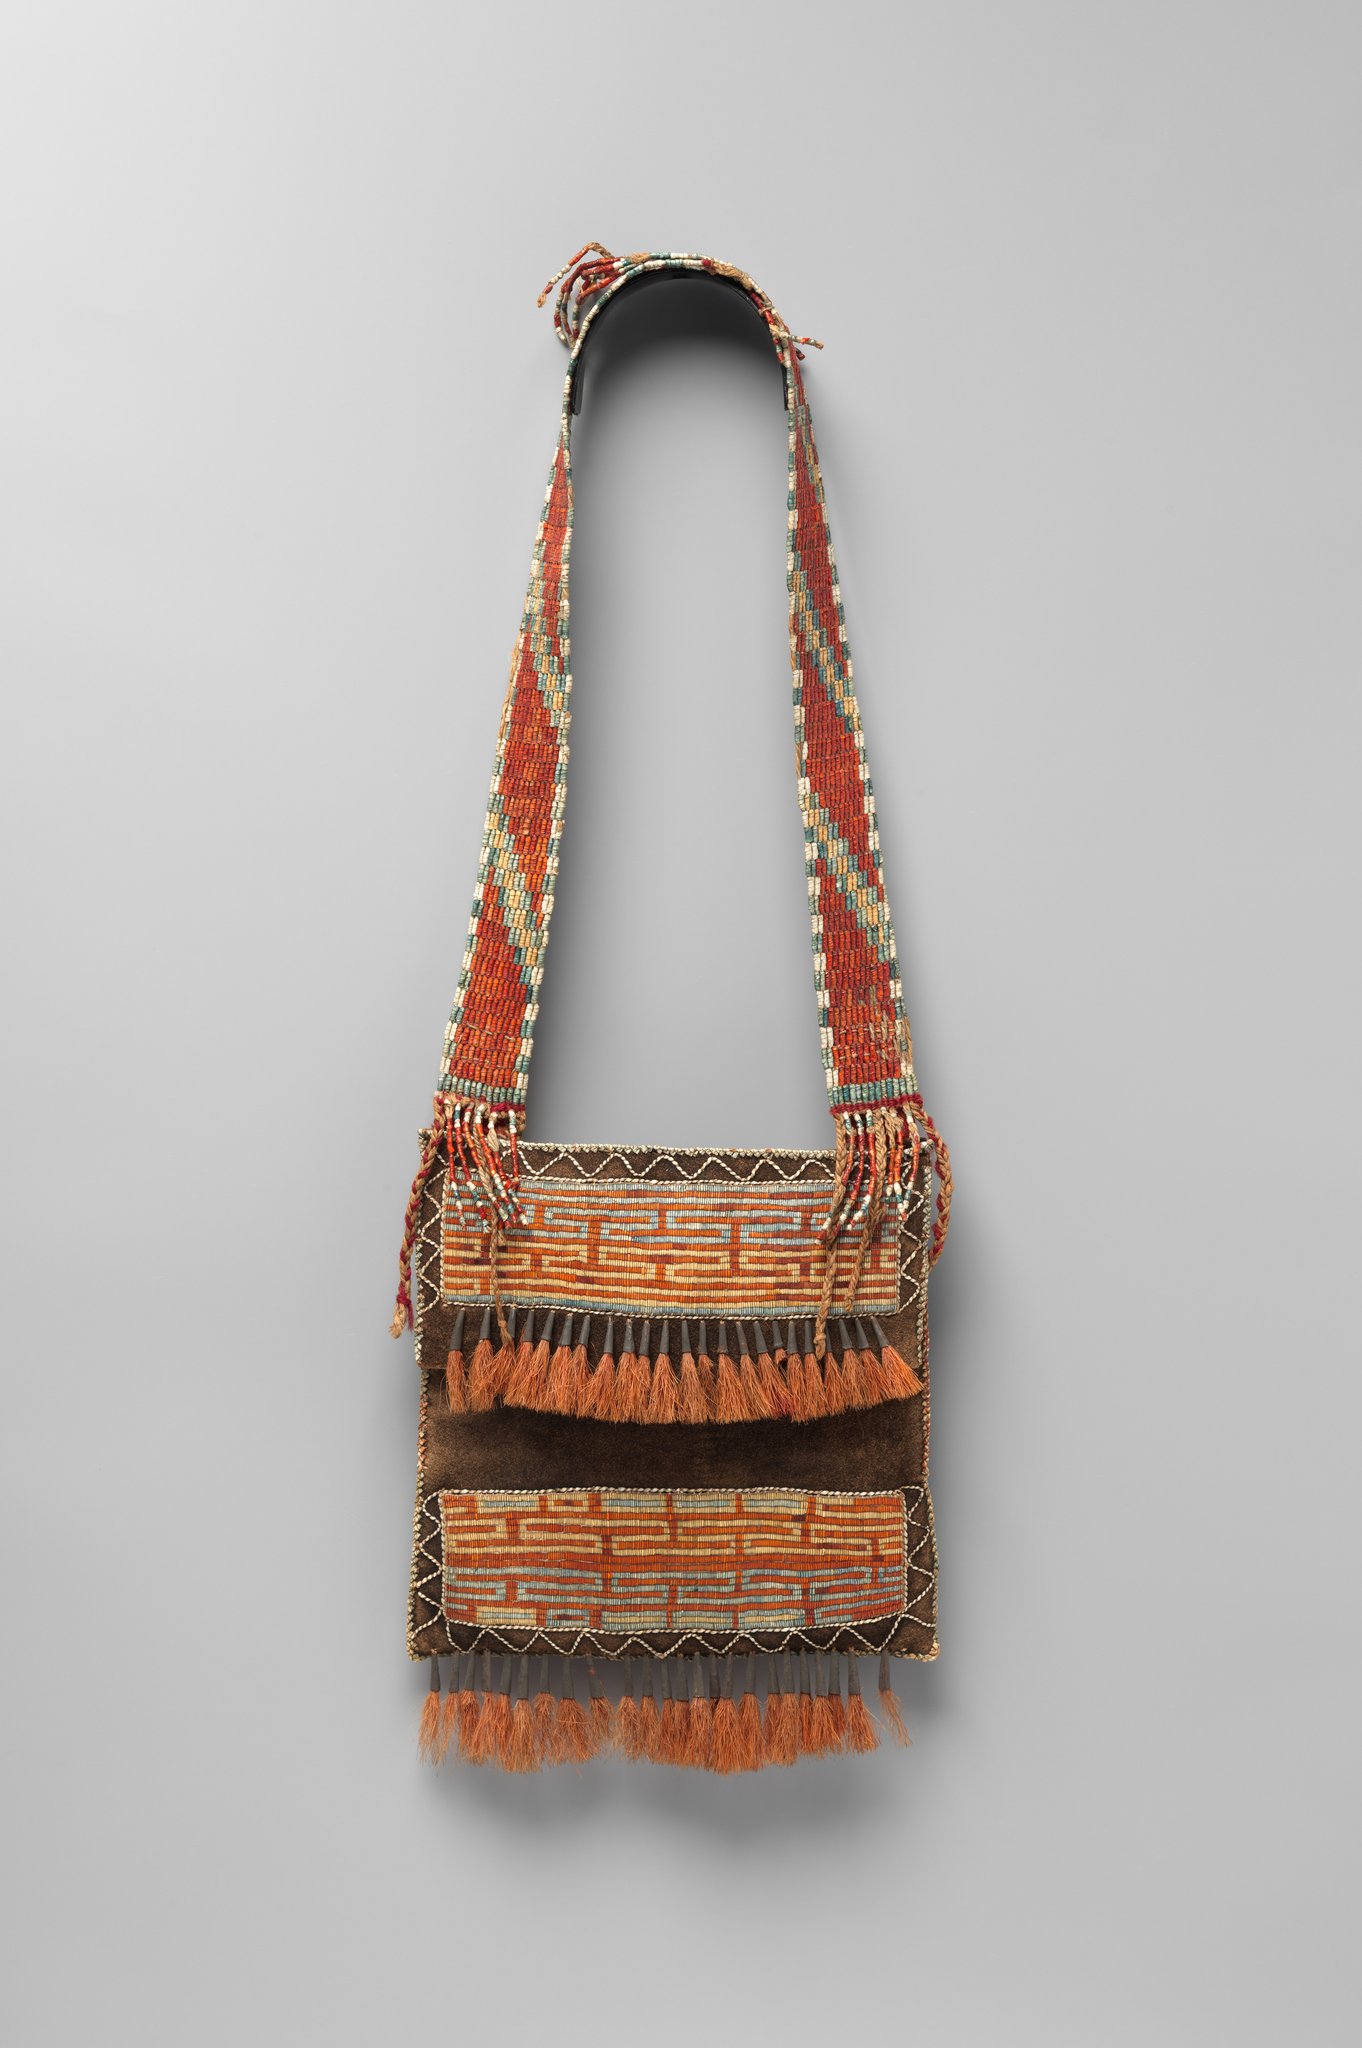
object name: bag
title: Shoulder bag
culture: anishinaabe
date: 1780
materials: dye, fiber, hair, leather, metal, wool, thread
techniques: tanning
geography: canada